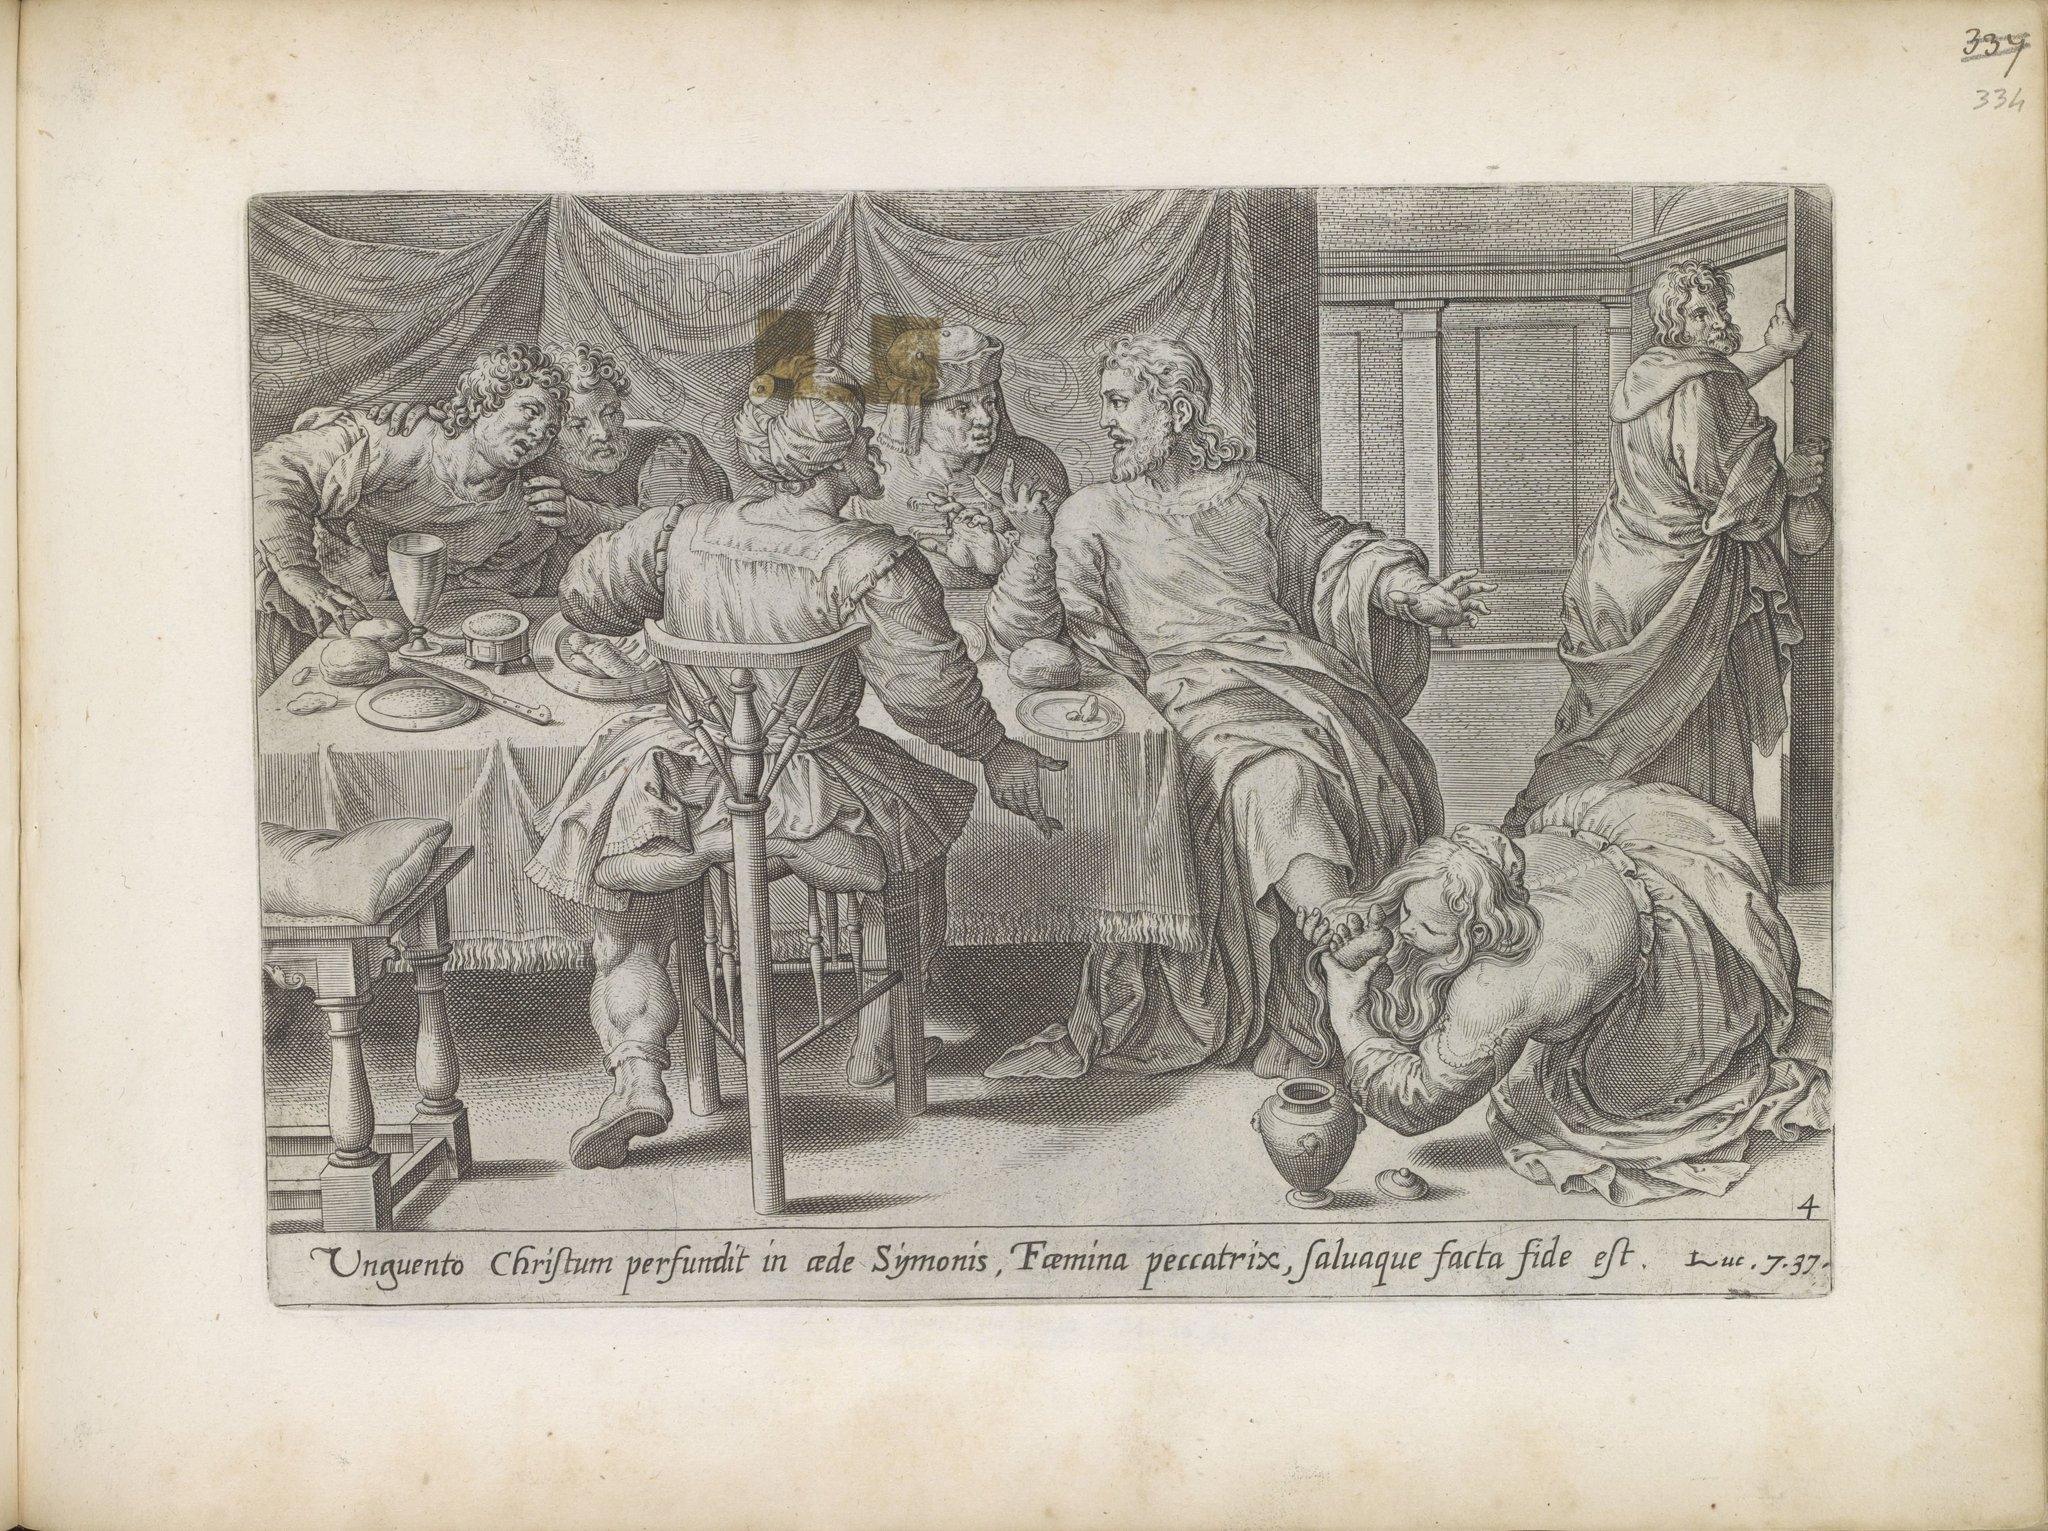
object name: print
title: Christus' voeten gezalfd door een zondares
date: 1585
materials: paper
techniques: engraving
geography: amsterdam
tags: a woman washes christ's feet with her tears, and wipes them with her hair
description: Christus is te gast voor de maaltijd in het huis van Simon de farizeeër. Een zondares zalft de voeten van Christus en droogt ze met haar haren. Naast haar staat de zalfpot. Christus is in gesprek met Simon. Onder de voorstelling een verwijzing in het Latijn naar de Bijbeltekst in Luc. 7. Deze prent maakt deel uit van een album.